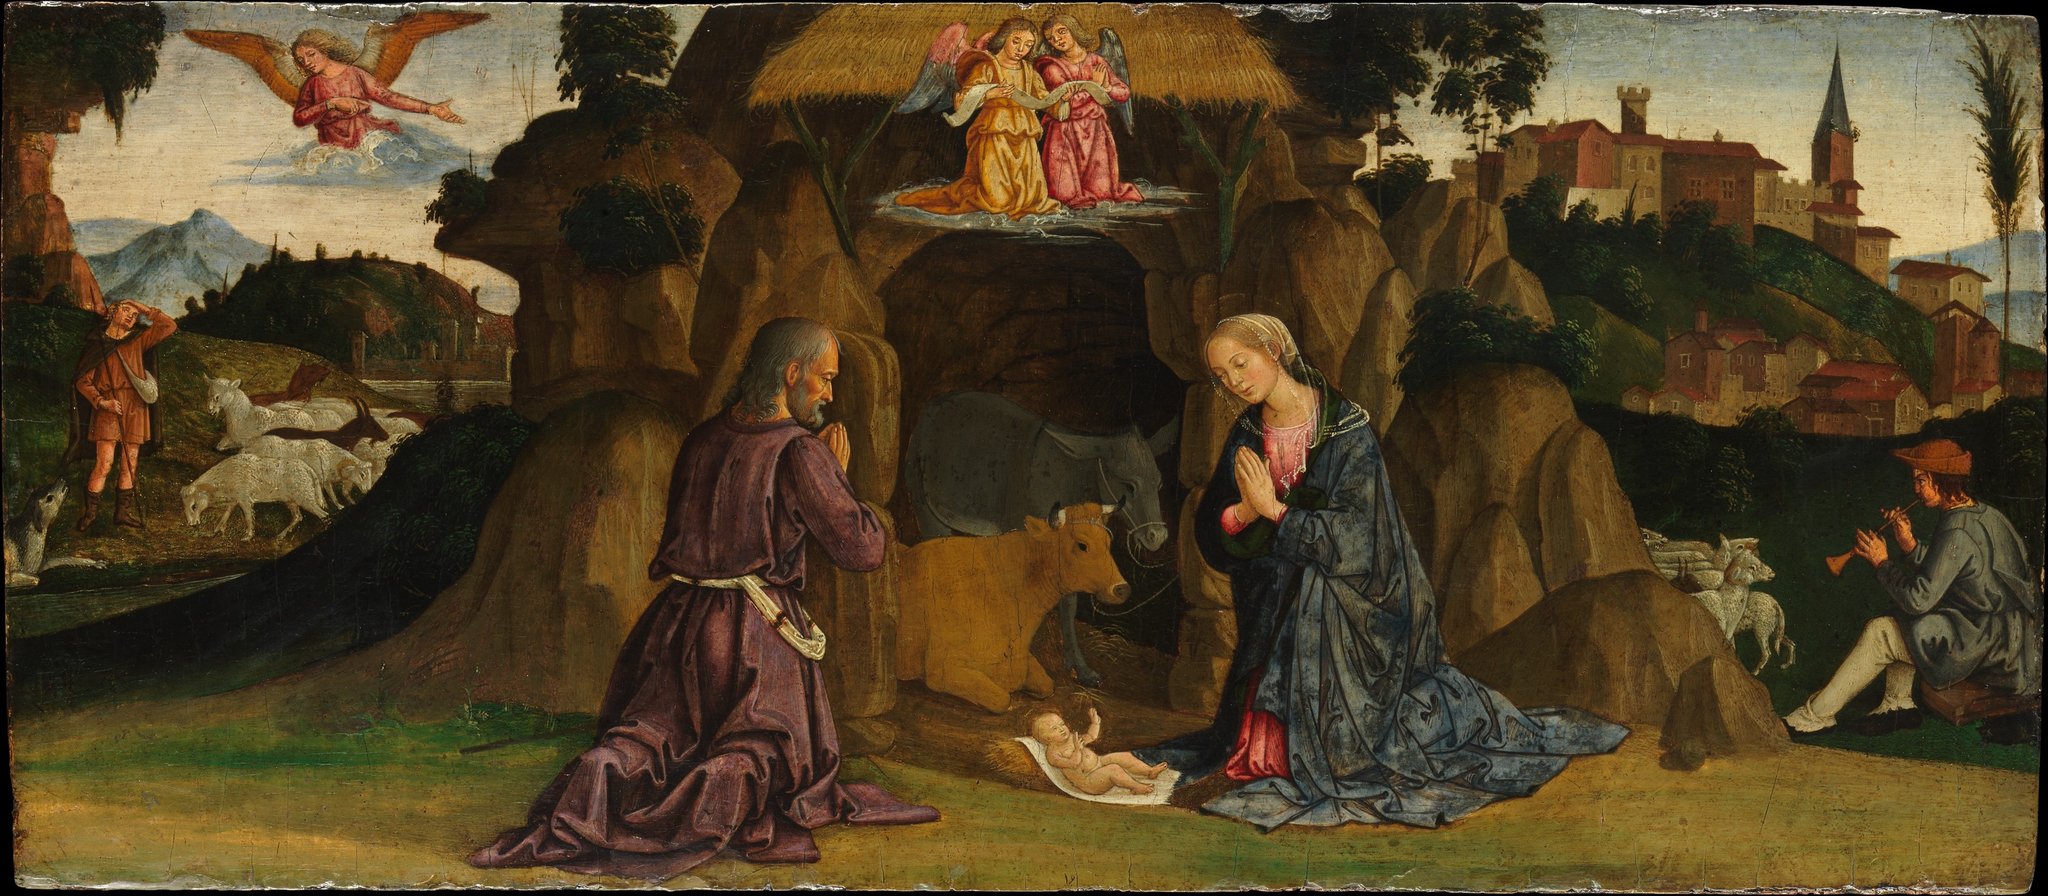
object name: painting, predella panel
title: The Nativity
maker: antoniazzo romano (antonio di benedetto aquilio)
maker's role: artist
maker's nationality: italian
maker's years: 1435-1508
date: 1480-1489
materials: paint, wood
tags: animals,donkeys,sheep,landscapes,angels,virgin mary,jesus,nativity